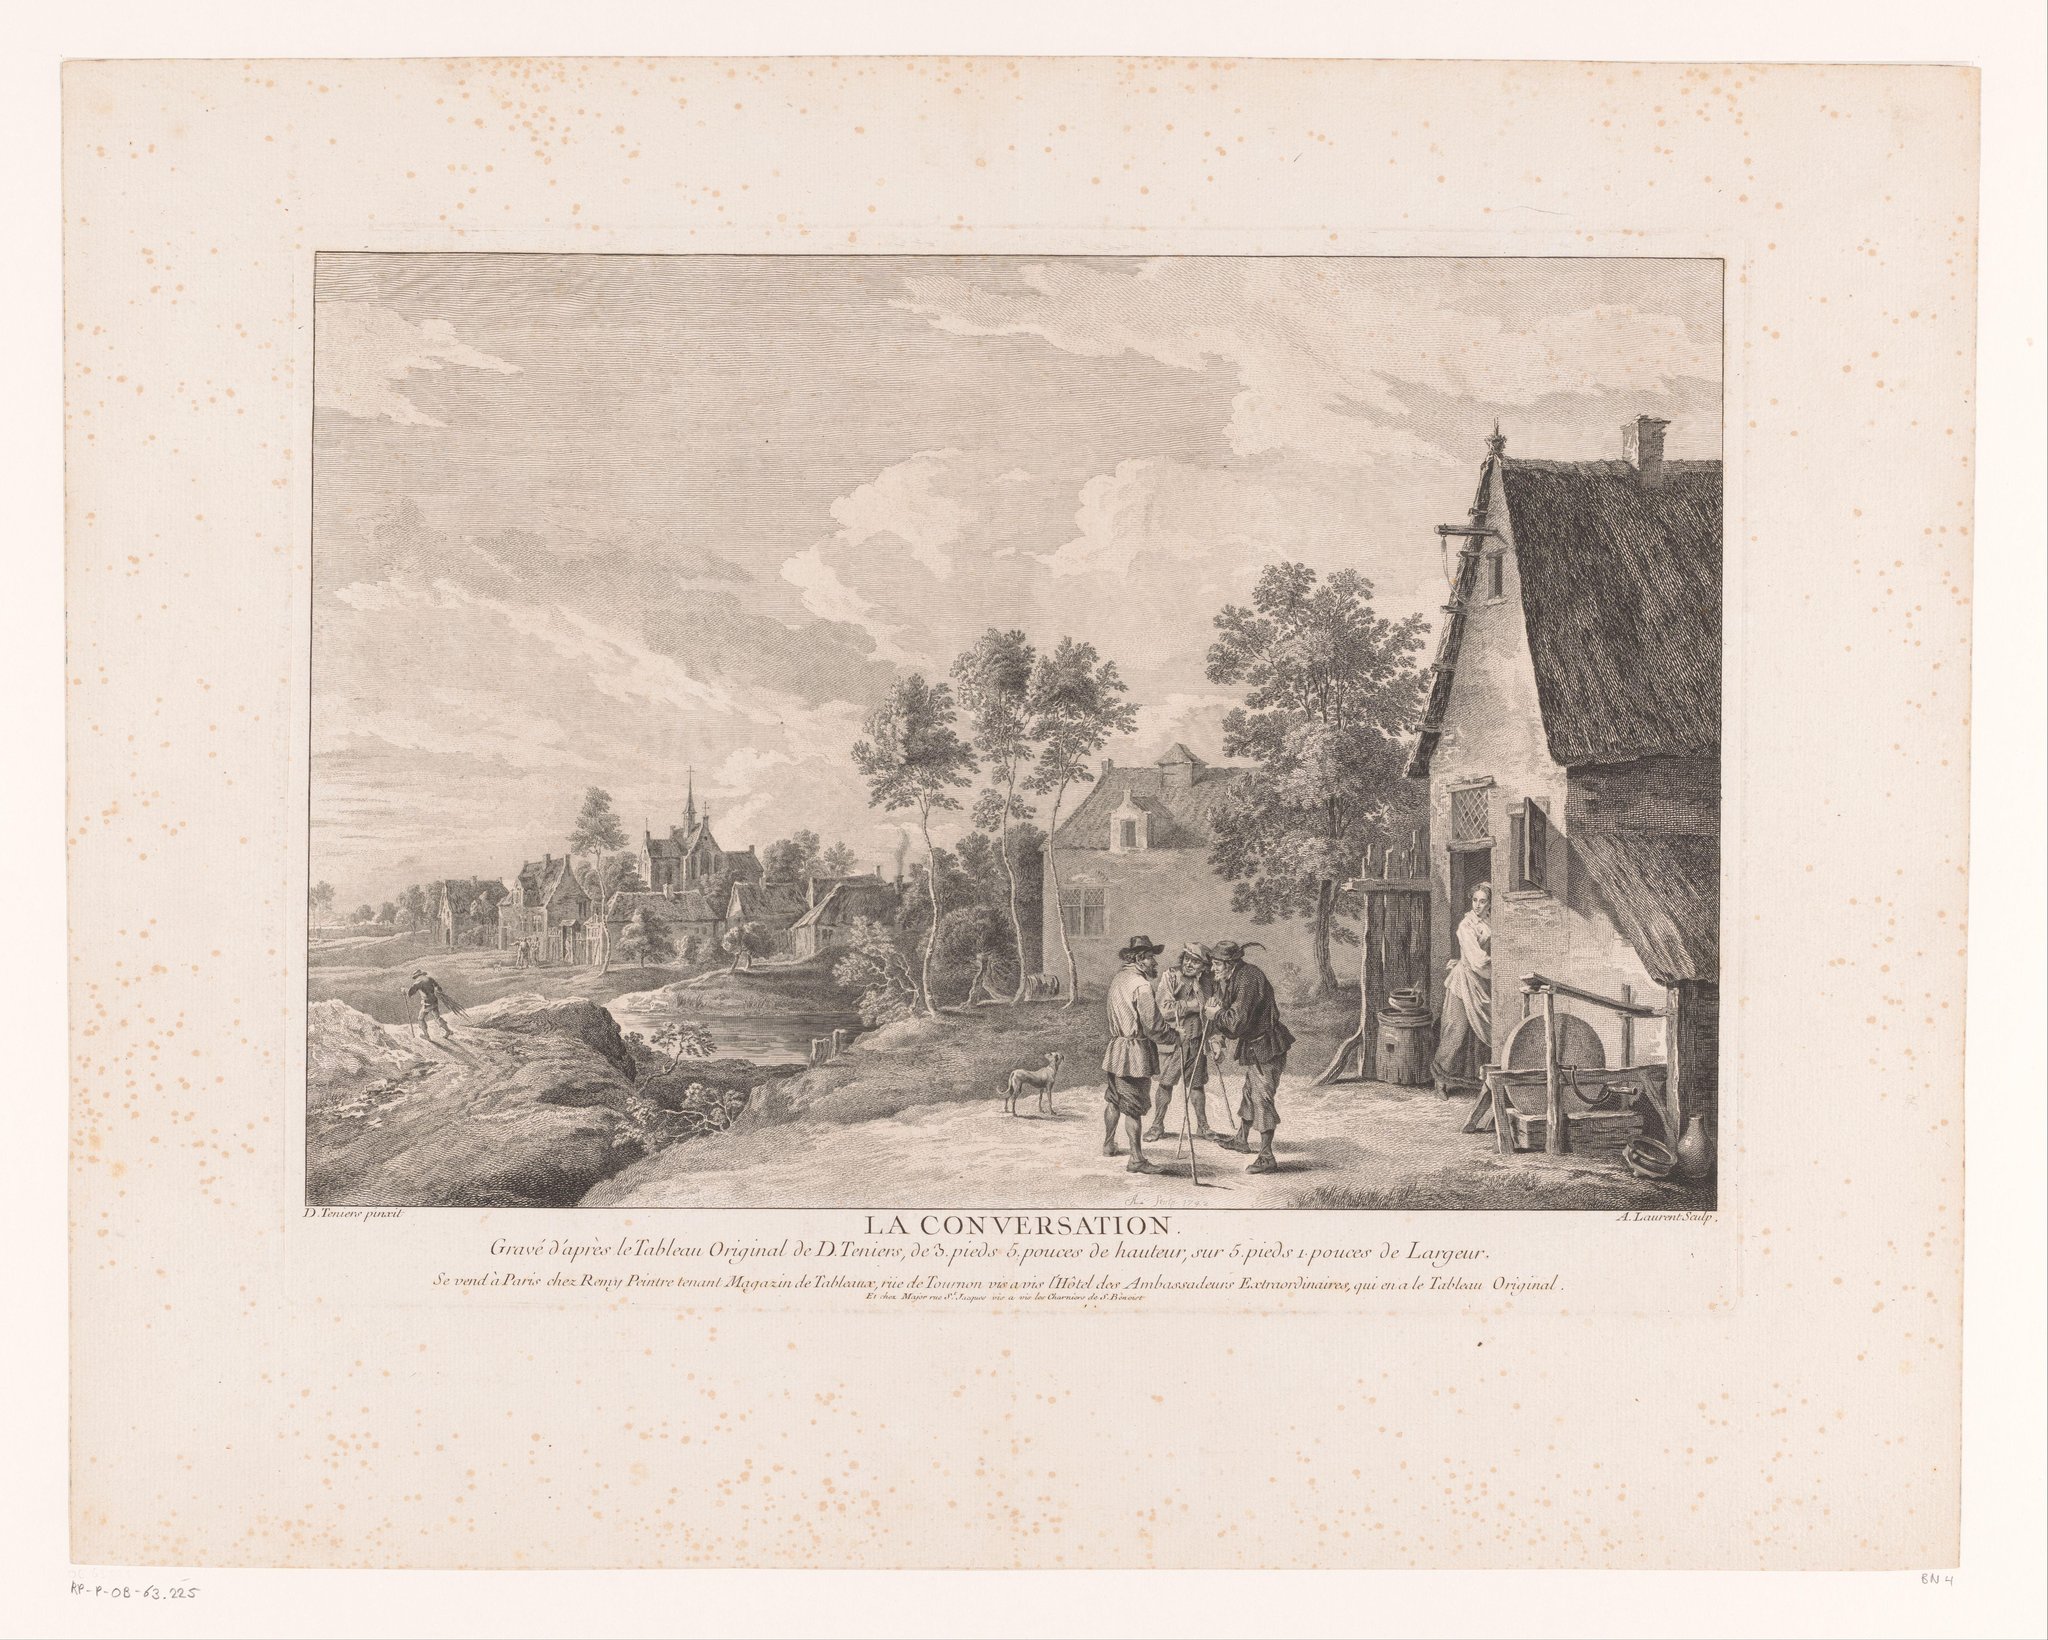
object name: print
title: La Conversation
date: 1742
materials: paper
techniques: engraving, etching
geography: paris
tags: tools, aids, implements ~ crafts and industries: grindstone, outskirts of village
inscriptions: collector's mark: Lugt 240